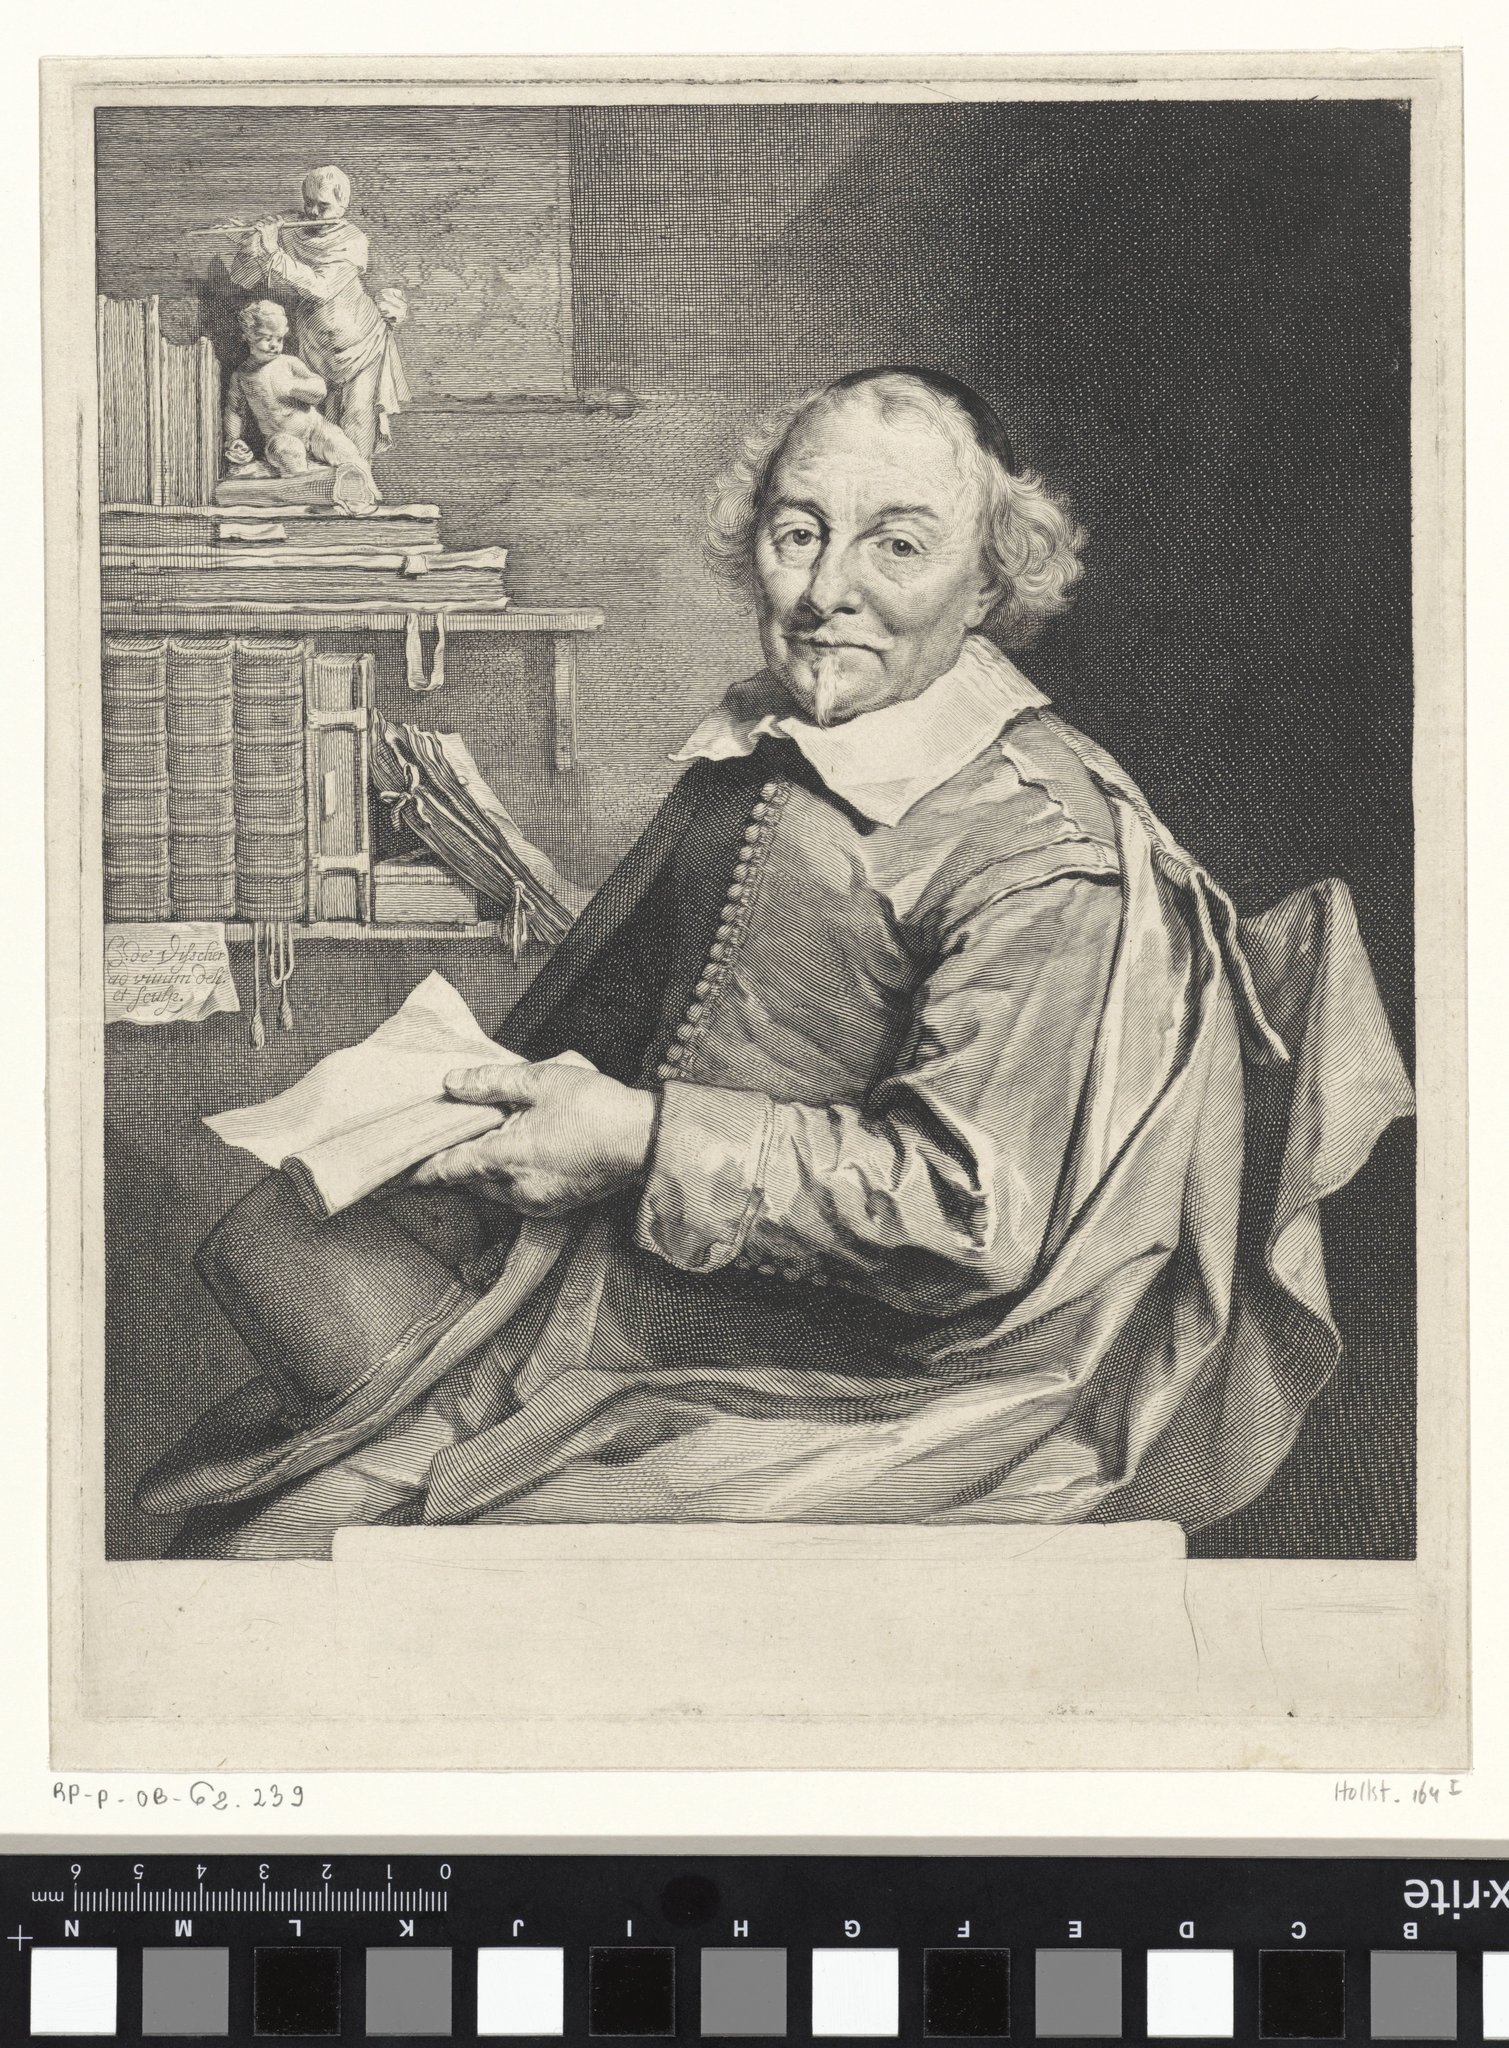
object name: print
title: Portret van Joost van den Vondel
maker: cornelis visscher (ii)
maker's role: draughtsman, painter, print maker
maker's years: 1628-1658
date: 1657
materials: paper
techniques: engraving, etching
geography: haarlem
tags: cologne, amsterdam, joost van den vondel, print, e.g.: engraving, etching, lithograph, head-gear: hat (+ men's clothes), book, sculpture, cupids: 'amores', 'amoretti', 'putti'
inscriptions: collector's mark: Lugt 240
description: De schrijver en dichter Joost van den Vondel op 70-jarige leeftijd in zijn werkkamer. Hij draagt een kalot en heeft een beschreven rol papier in zijn hand. Hij zit bij twee planken met boeken en beelden van een fluitspelende man en een putto. Aan de muur hangt een op stokken geslagen prent.